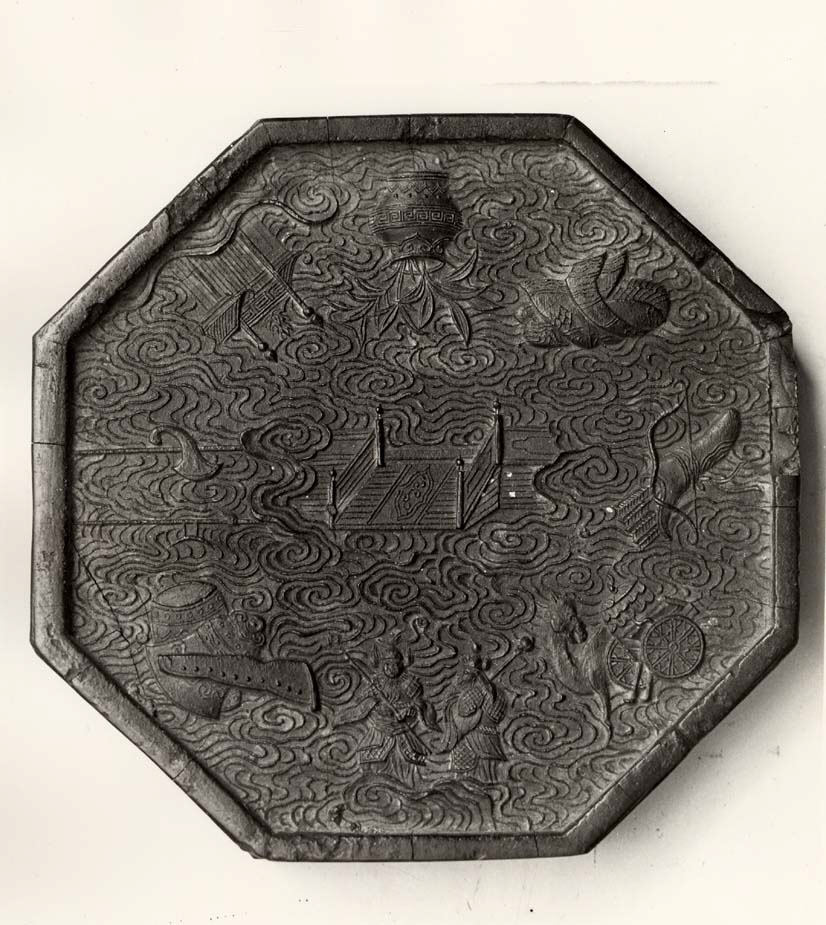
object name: ink tablet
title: Ink Tablet Decorated with Emblems of Investiture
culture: chinese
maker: fang yulu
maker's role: artist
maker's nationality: chinese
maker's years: 1570-1619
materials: wood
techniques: bookbinding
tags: bow and arrow,men,dragons